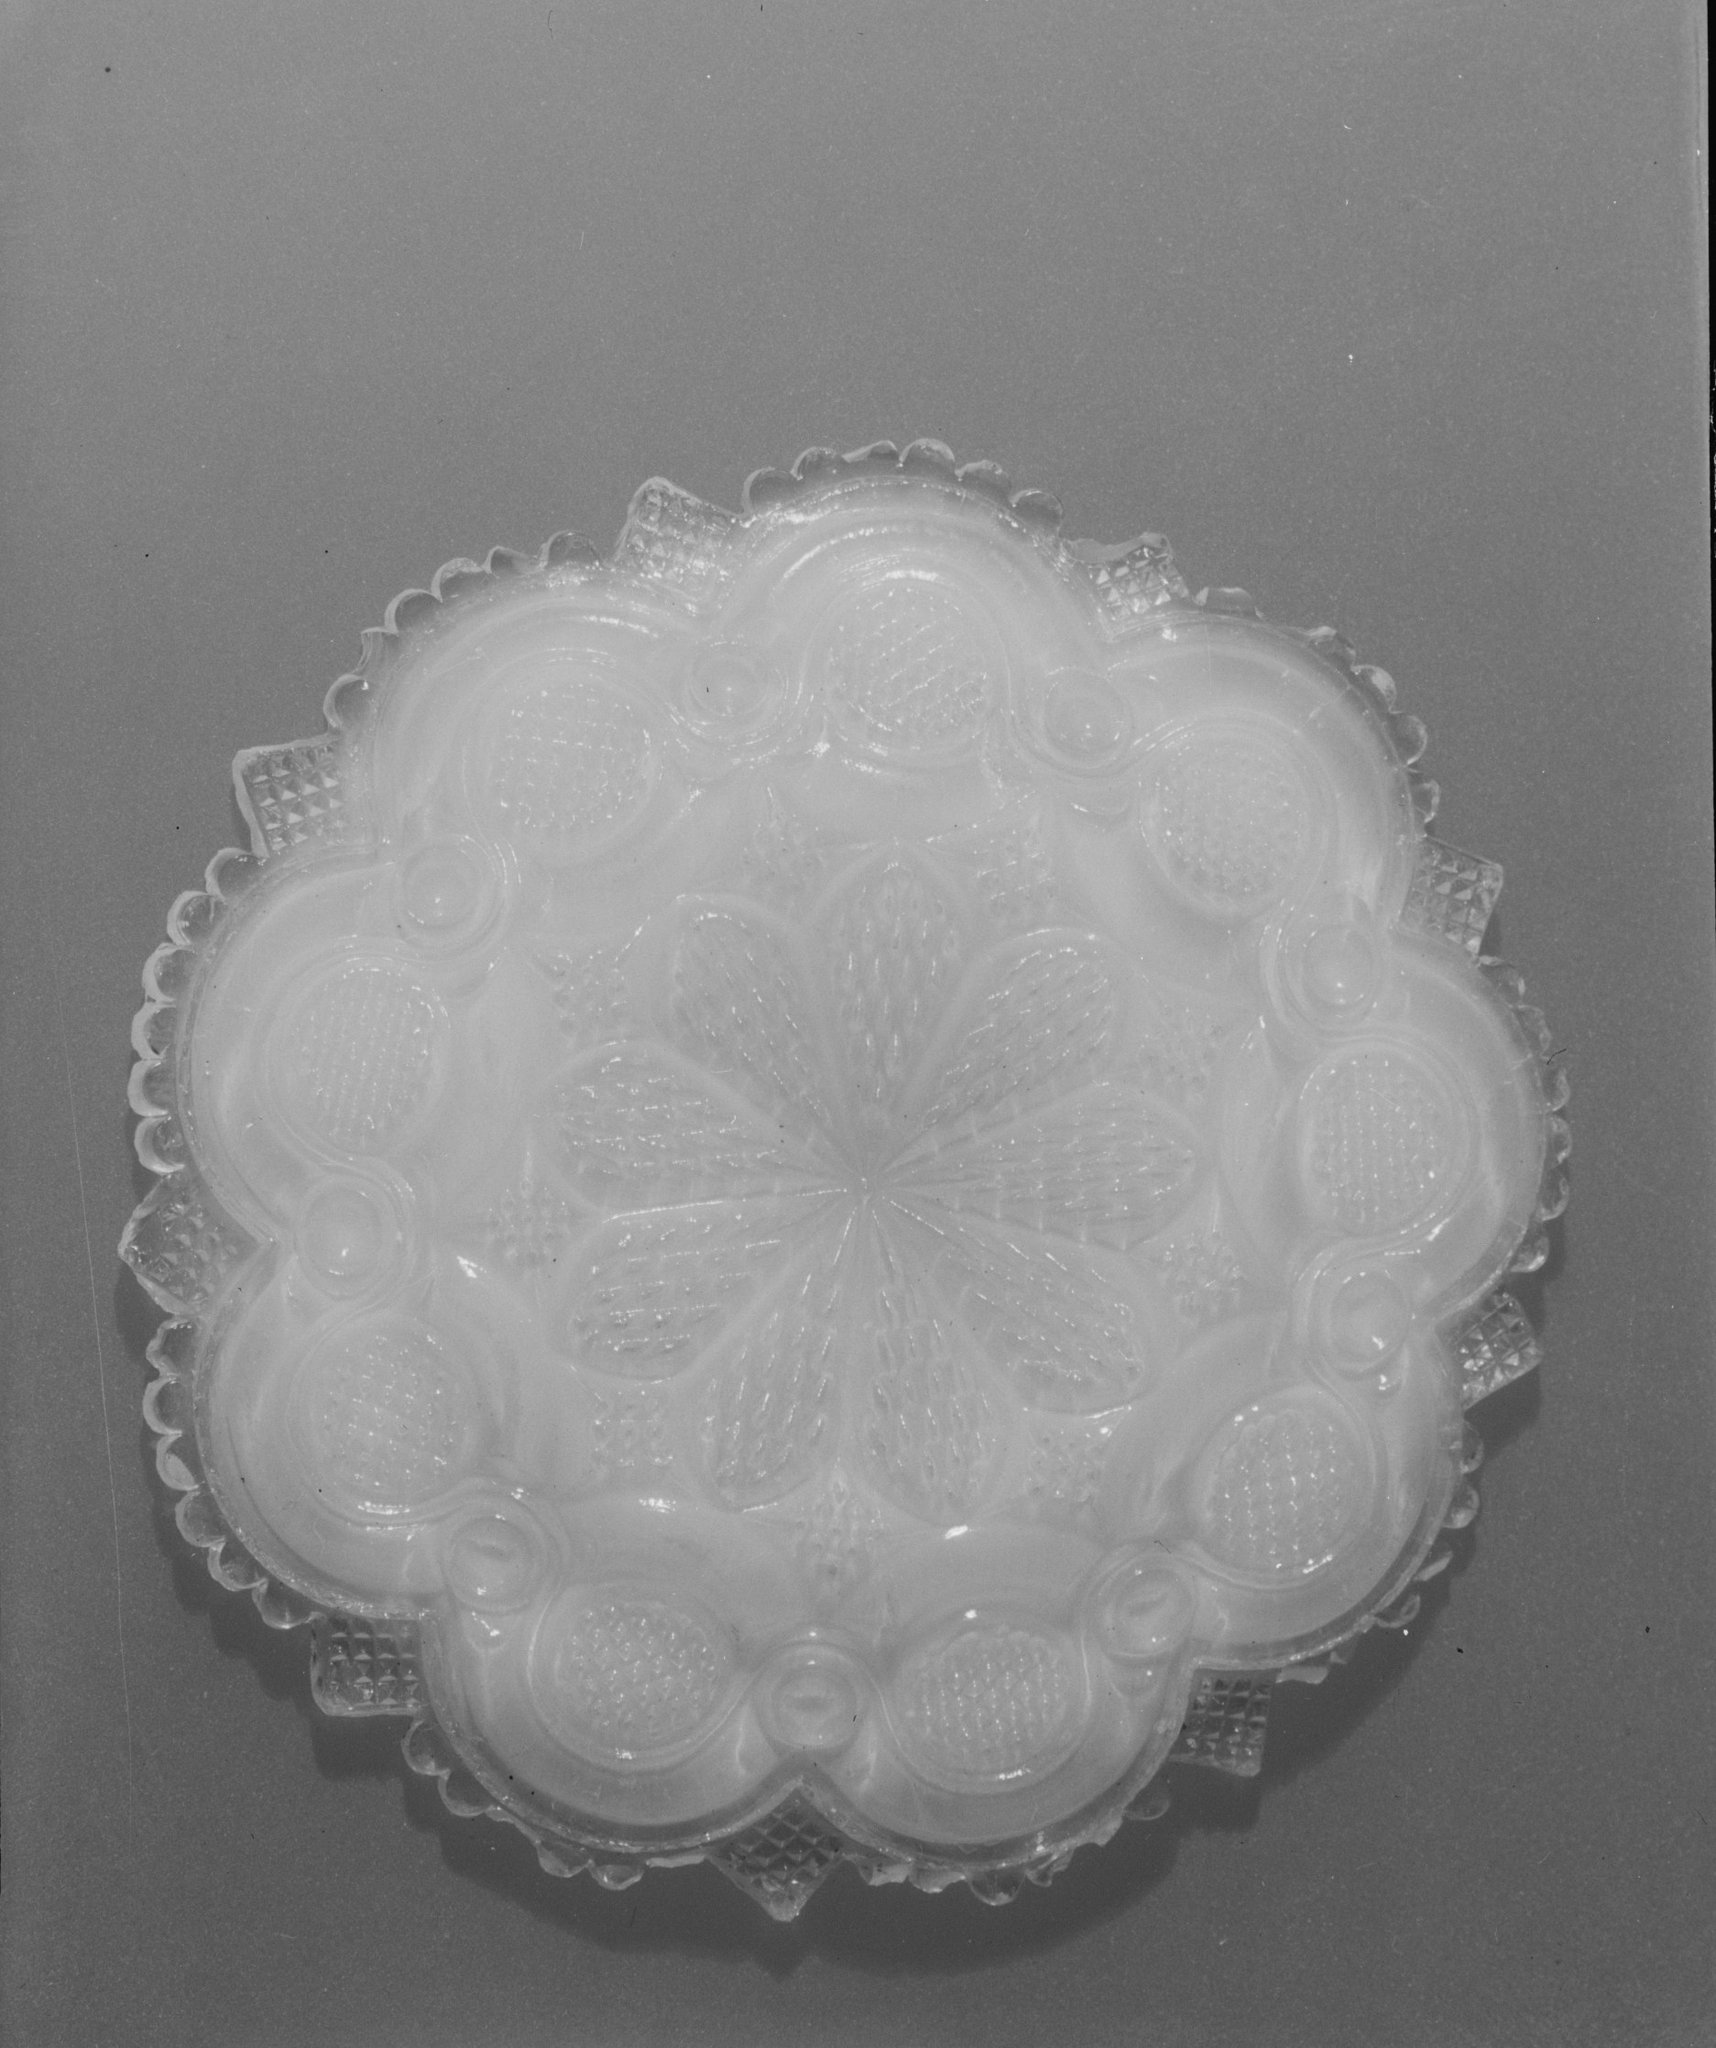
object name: plate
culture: american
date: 1835-1840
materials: glass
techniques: pressed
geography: united states